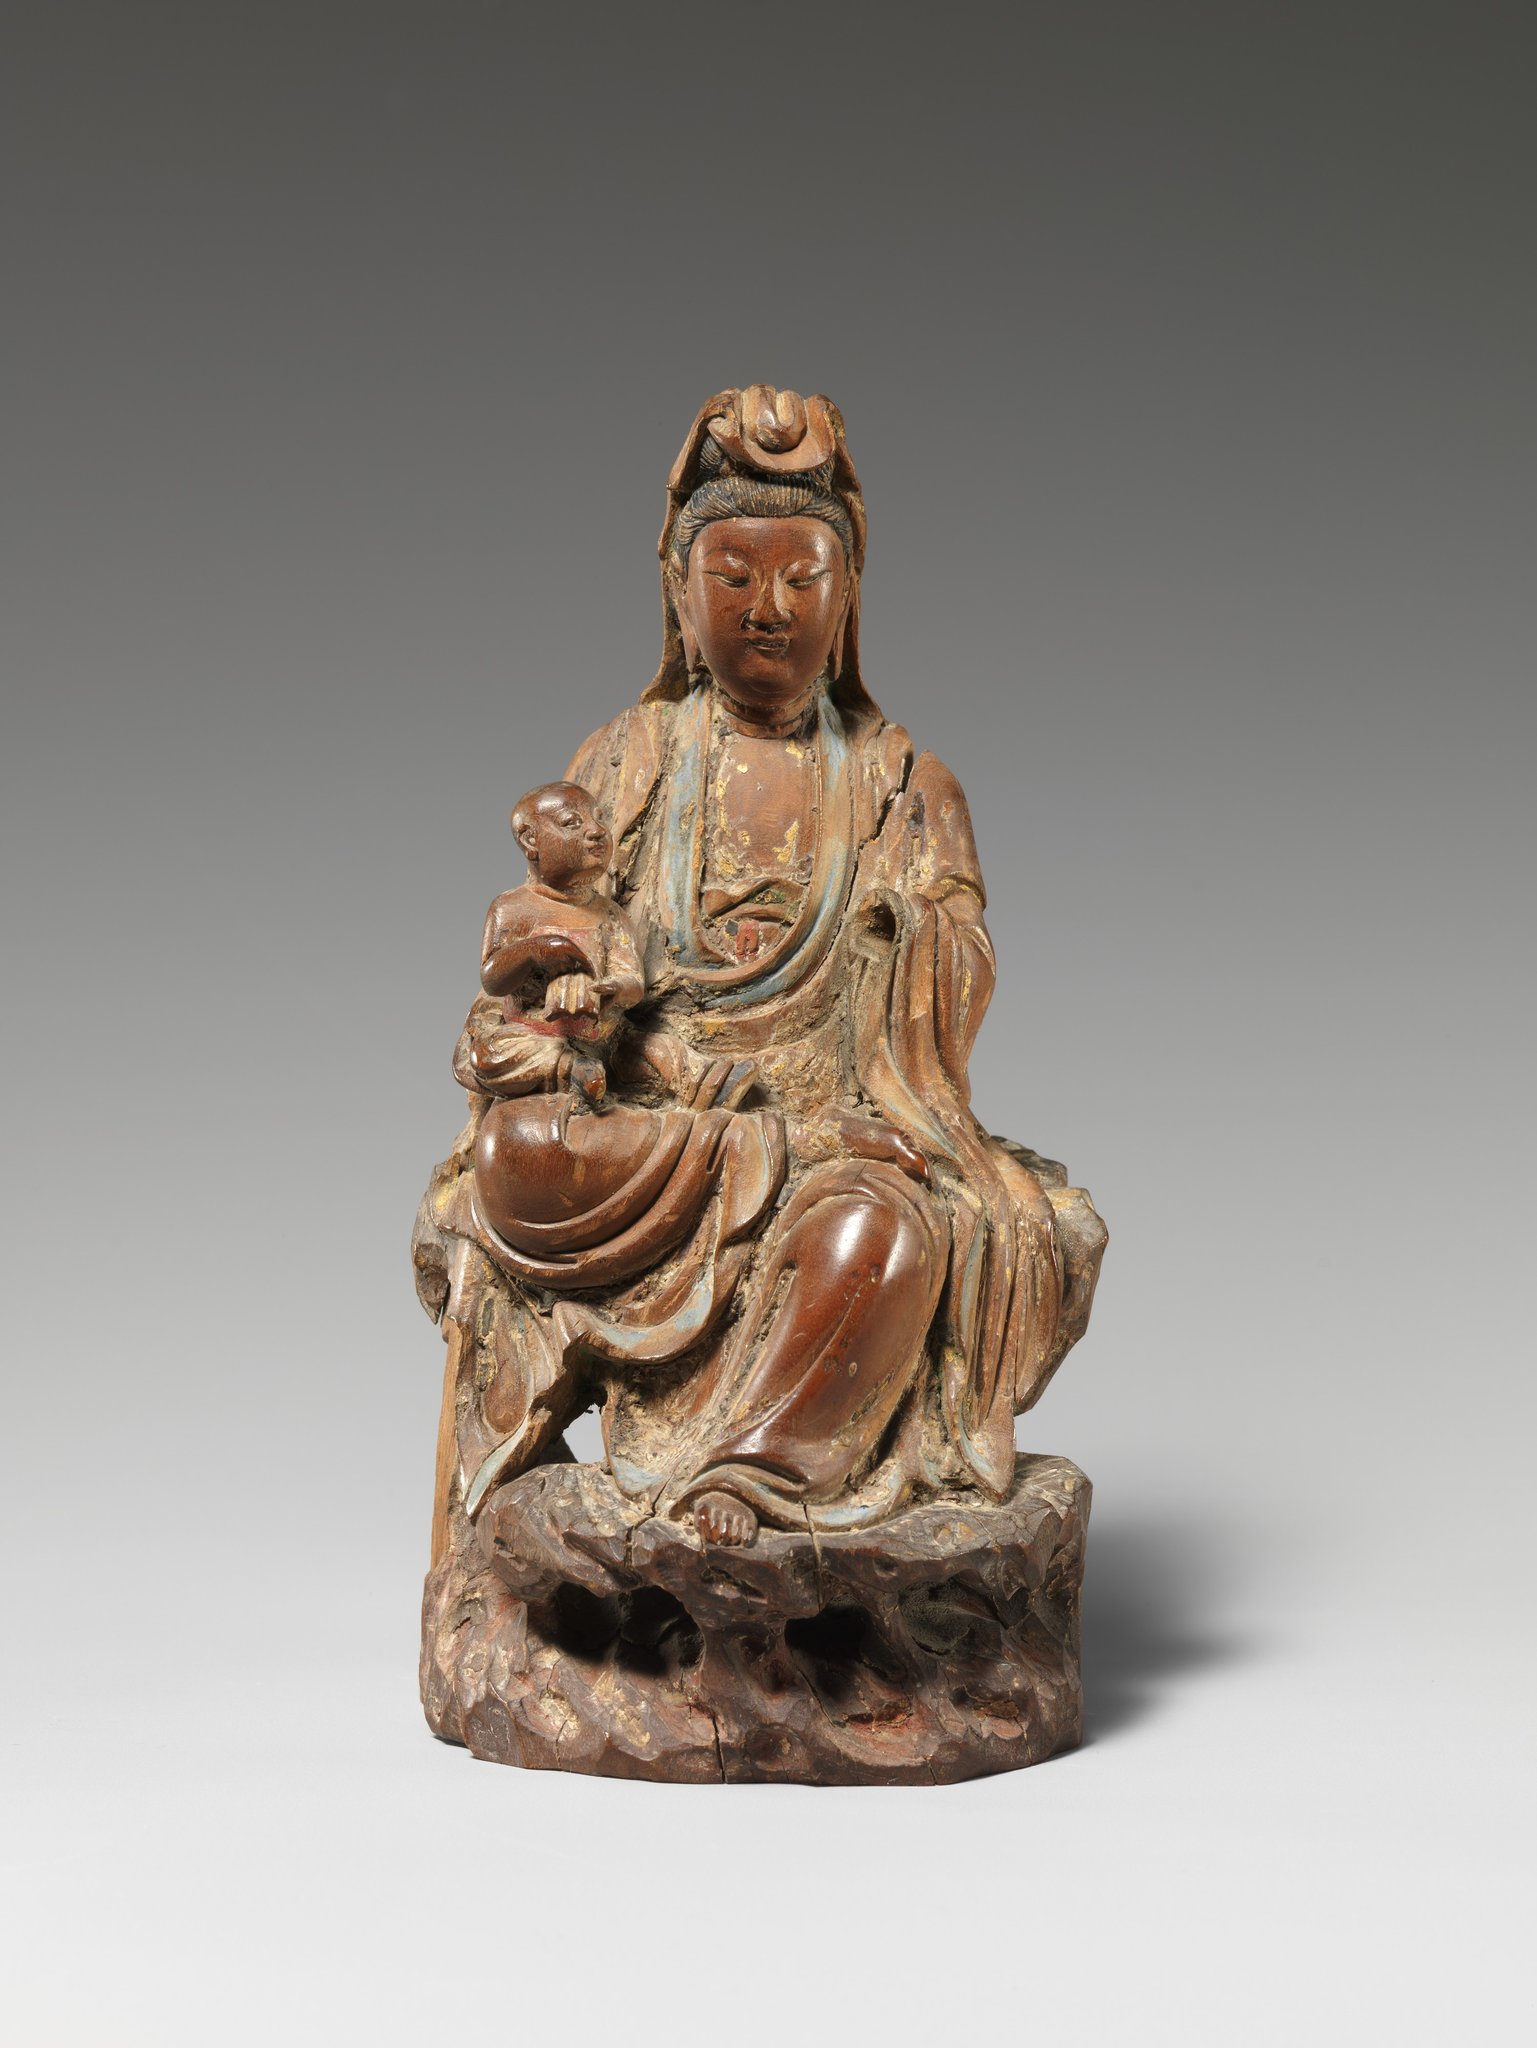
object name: figure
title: Guanyin the Bringer of Sons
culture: chinese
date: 1601-1700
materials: pigment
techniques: gilding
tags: children,buddhism,avalokiteshvara,bodhisattvas